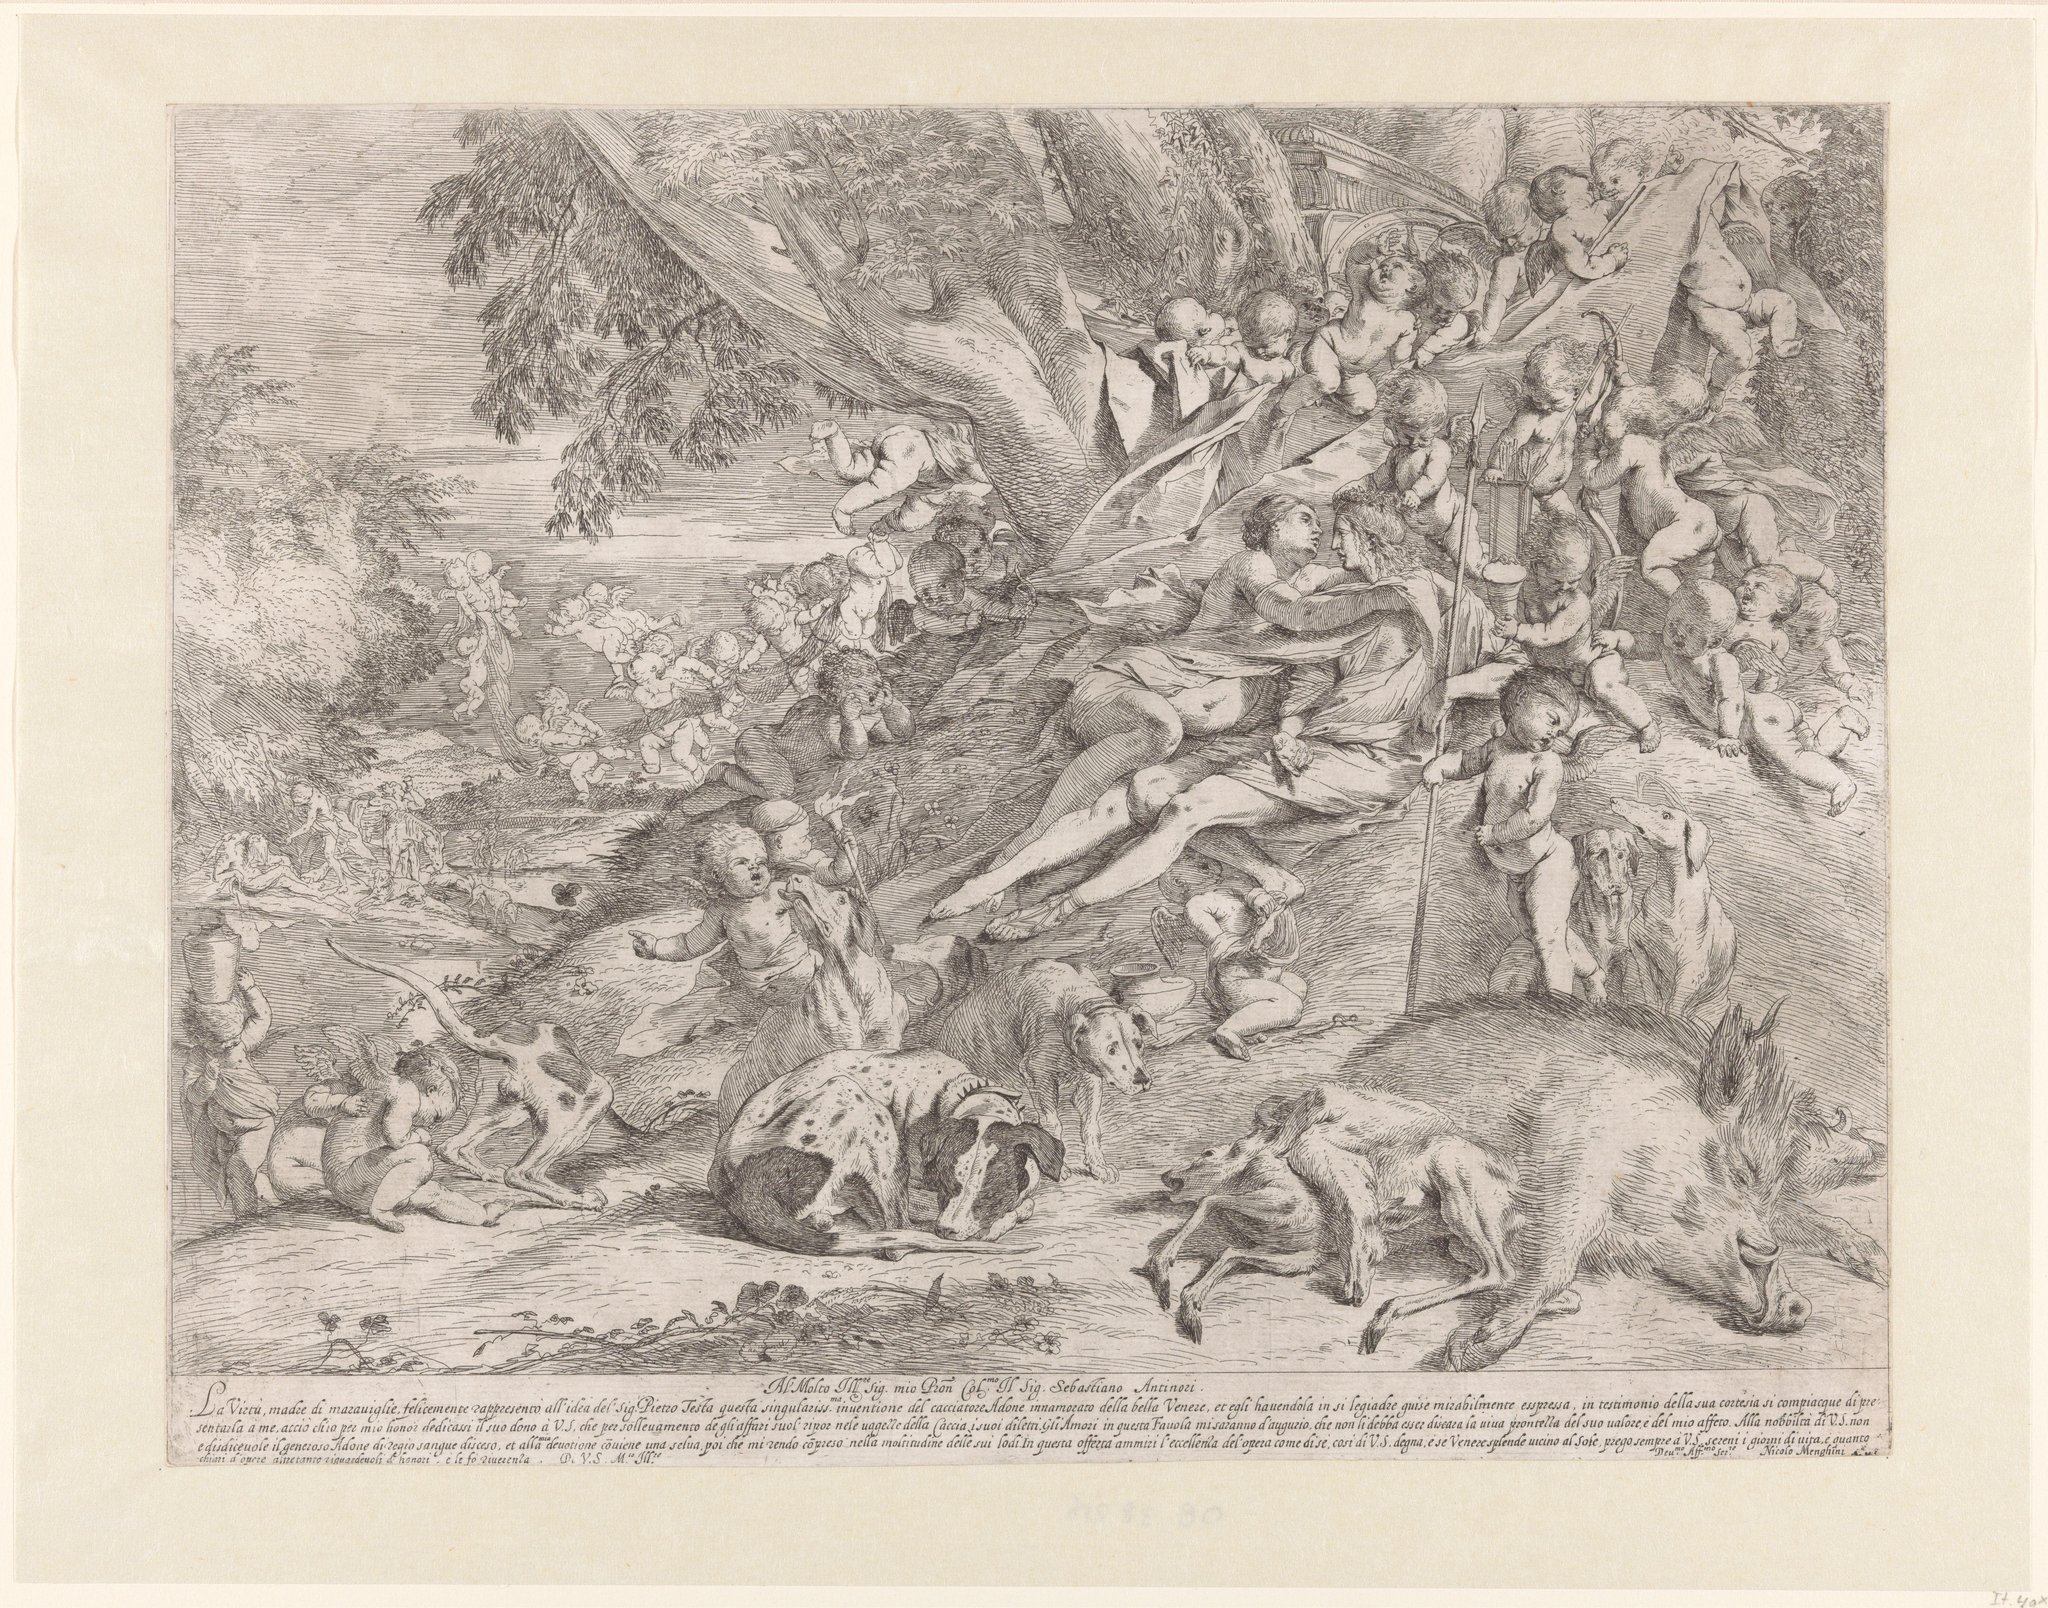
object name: print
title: Venus en Adonis na de jacht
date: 1632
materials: paper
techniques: etching, intaglio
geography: italy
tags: hunting dogs, boar-hunting, cupids: 'amores', 'amoretti', 'putti', group of various hunted animals, venus and adonis as lovers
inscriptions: collector's mark: Lugt 240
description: Venus en Adonis als geliefden, omgeven door putti. Op de voorgrond jachthonden en een jachtbuit waaronder een wild zwijn. Opdracht in ondermarge.